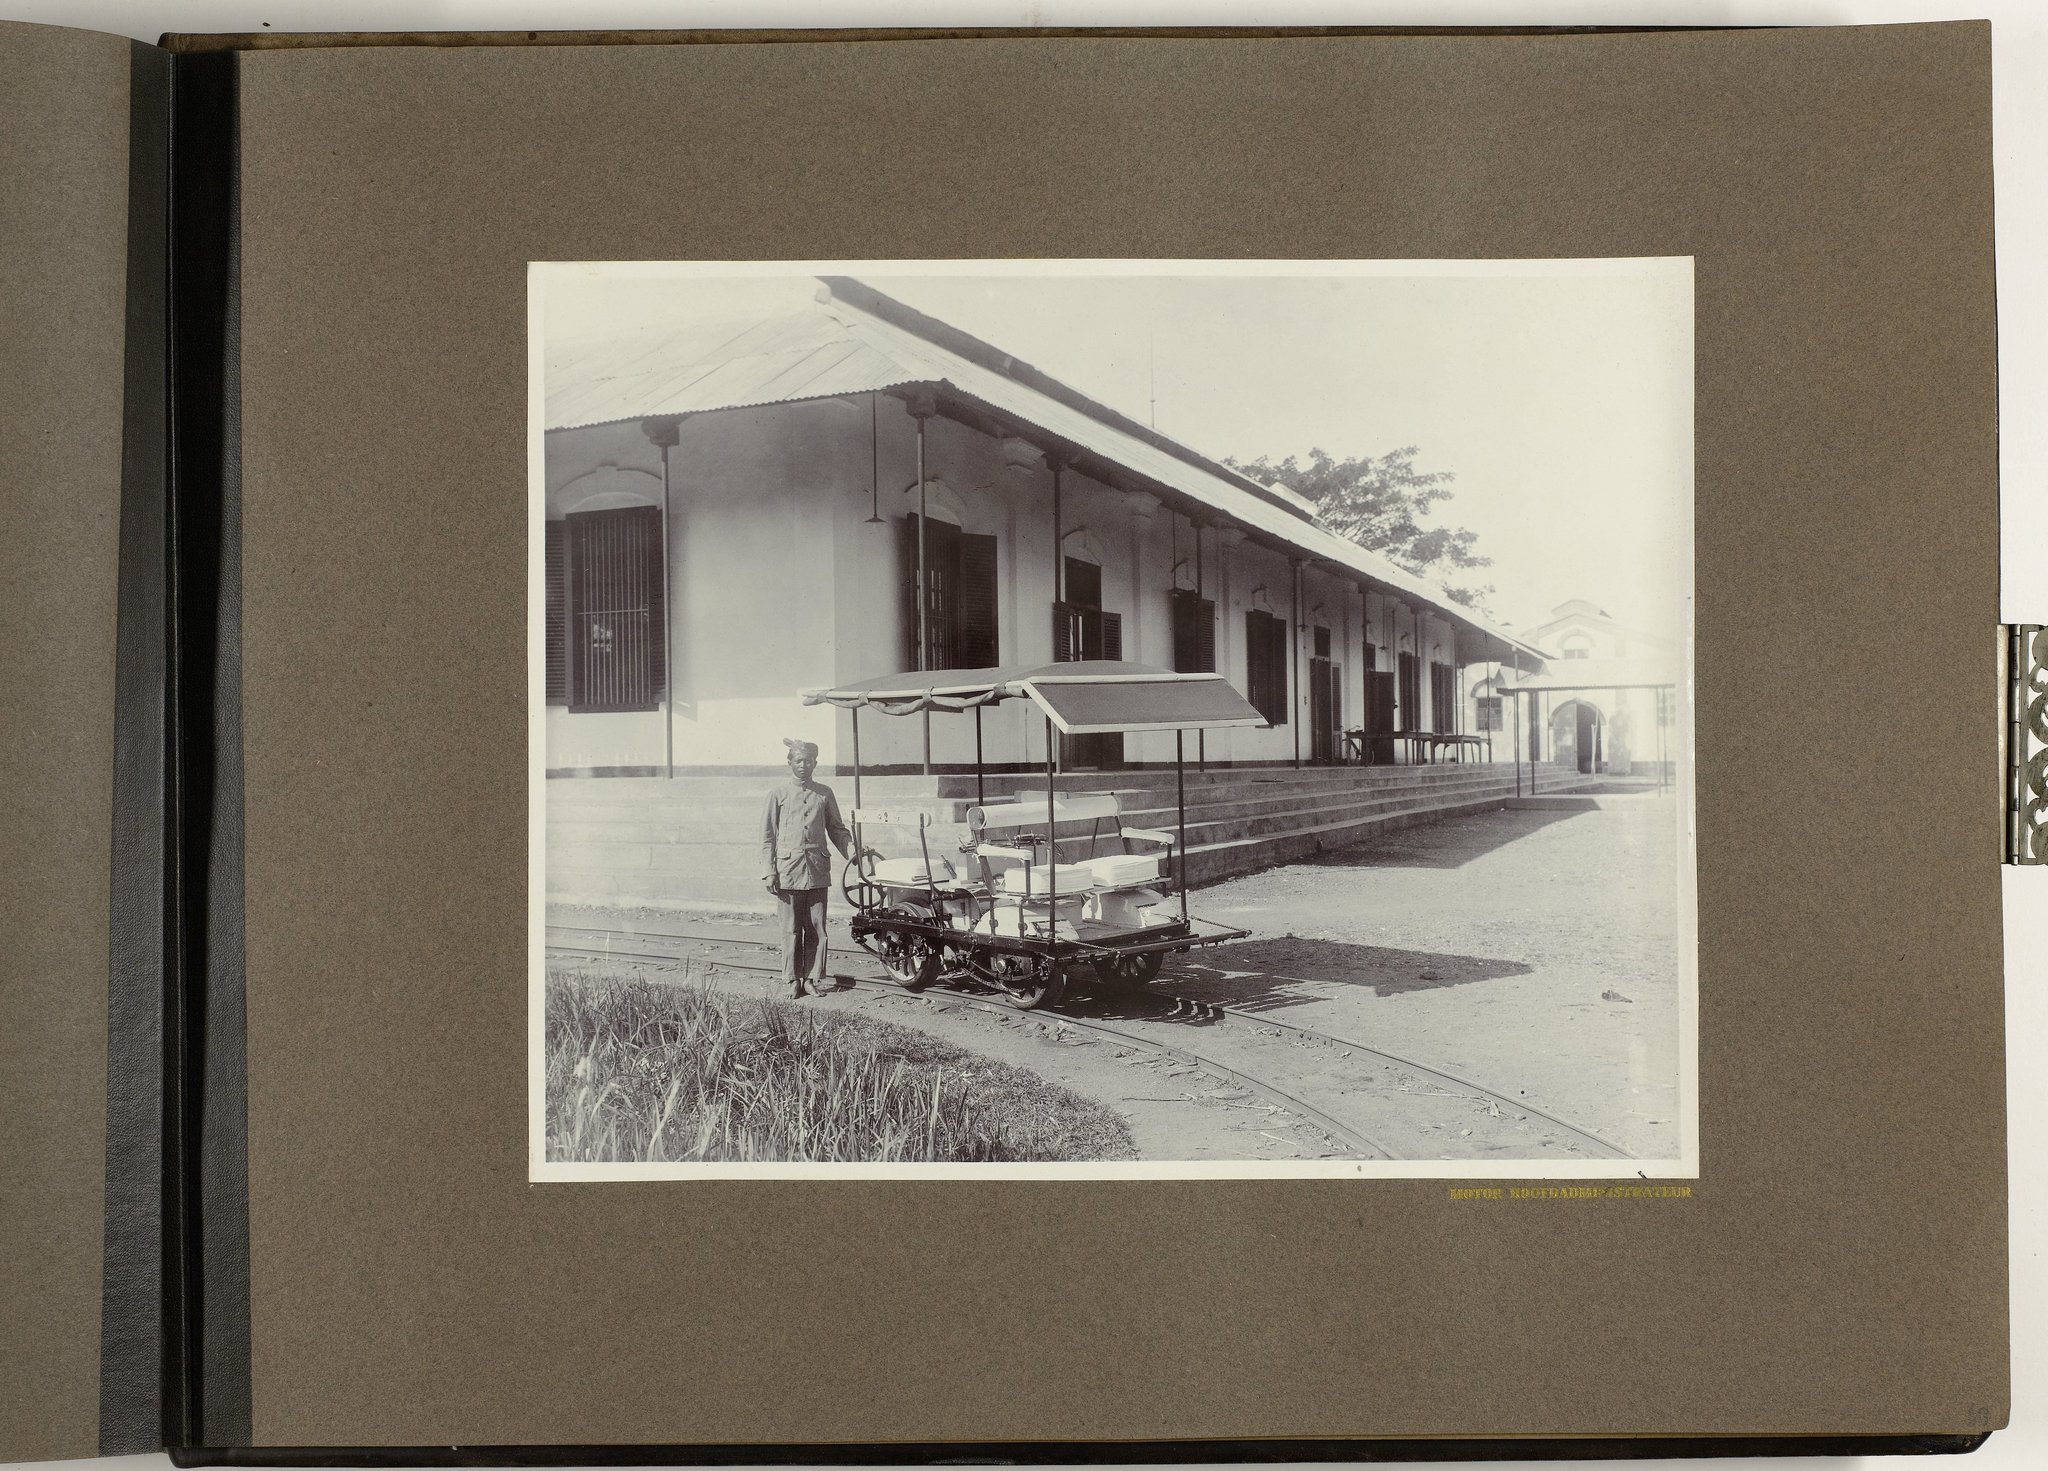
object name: photograph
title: Motor hoofdadministrateur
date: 1917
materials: photographic support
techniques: gelatin silver print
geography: jatiroto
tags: colonial system, motor-cycles and other two-wheeled motor-vehicles, (non-fruit) products of plants or trees: sugarcane, villa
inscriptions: inscription: ‘MOTOR HOOFDADMINISTRATEUR’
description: Motorlorrie van de hoofdadministrateur F.J. Wirix, op rails met daarnaast een bediende. Achter de lorrie of draisine het fabriekskantoor. Onderdeel van het fotoalbum aangeboden aan F.J. Wirix door het personeel van de Suikeronderneming Djatiroto in 1917.